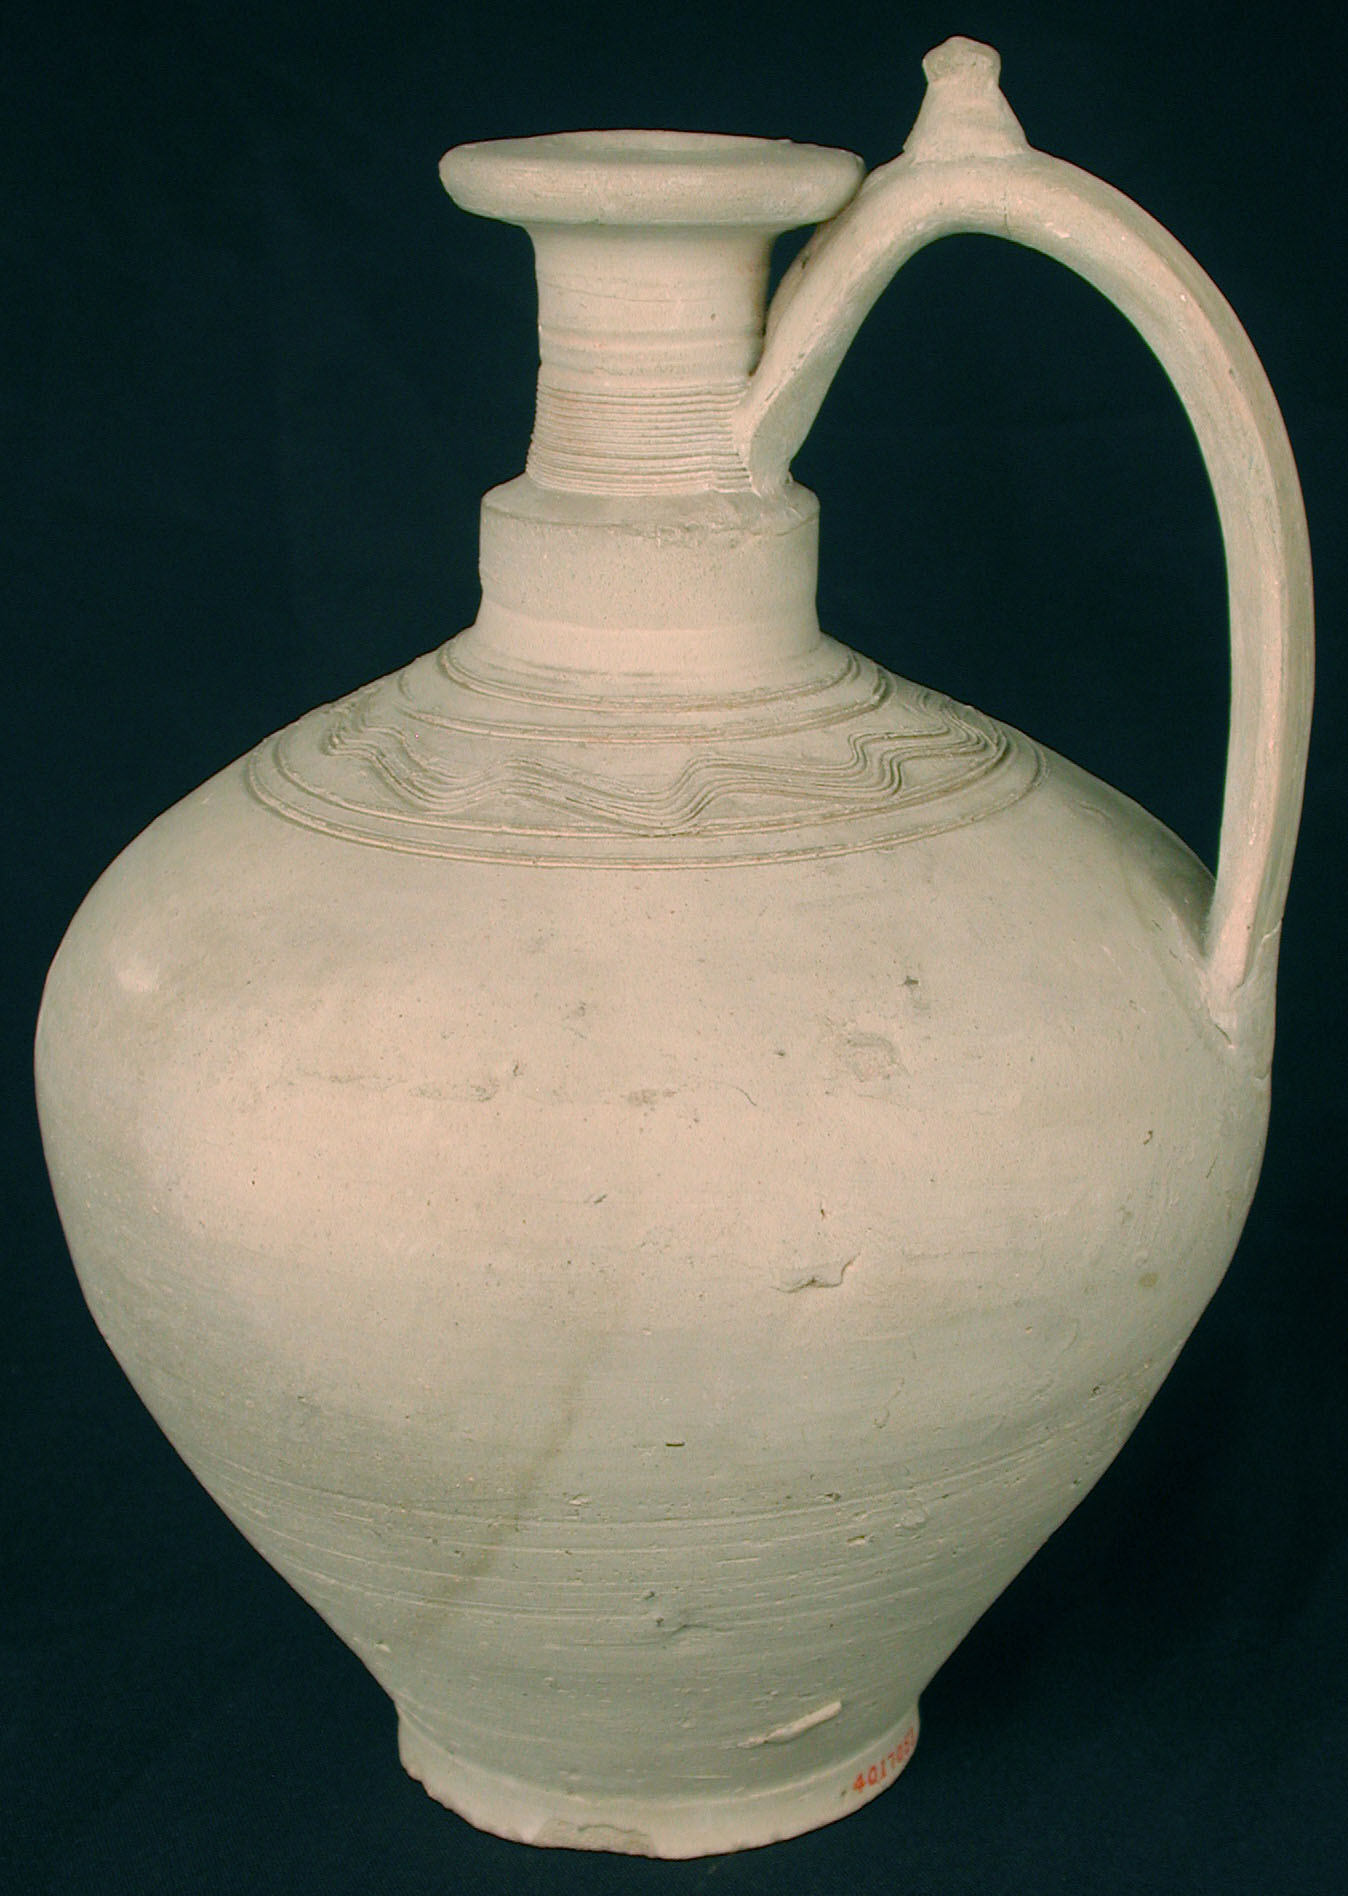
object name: ewer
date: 801-1000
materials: earthenware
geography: iran